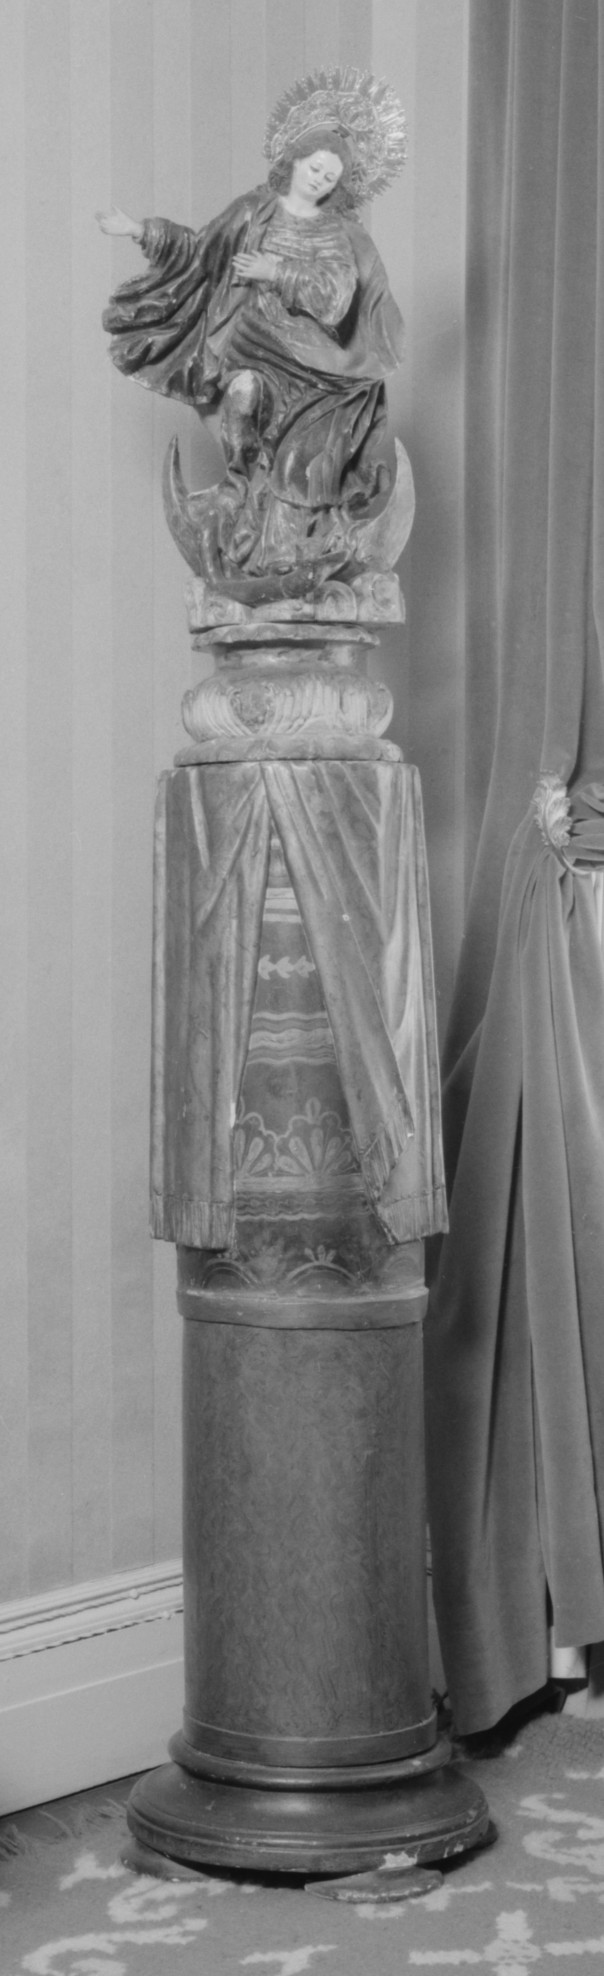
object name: statuette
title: Virgin of Quito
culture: ecuadorian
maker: bernardo legarda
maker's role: artist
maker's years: 1731-1773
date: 1701-1800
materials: glass, silver, wood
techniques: gilding, polychrome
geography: ecuador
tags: virgin mary